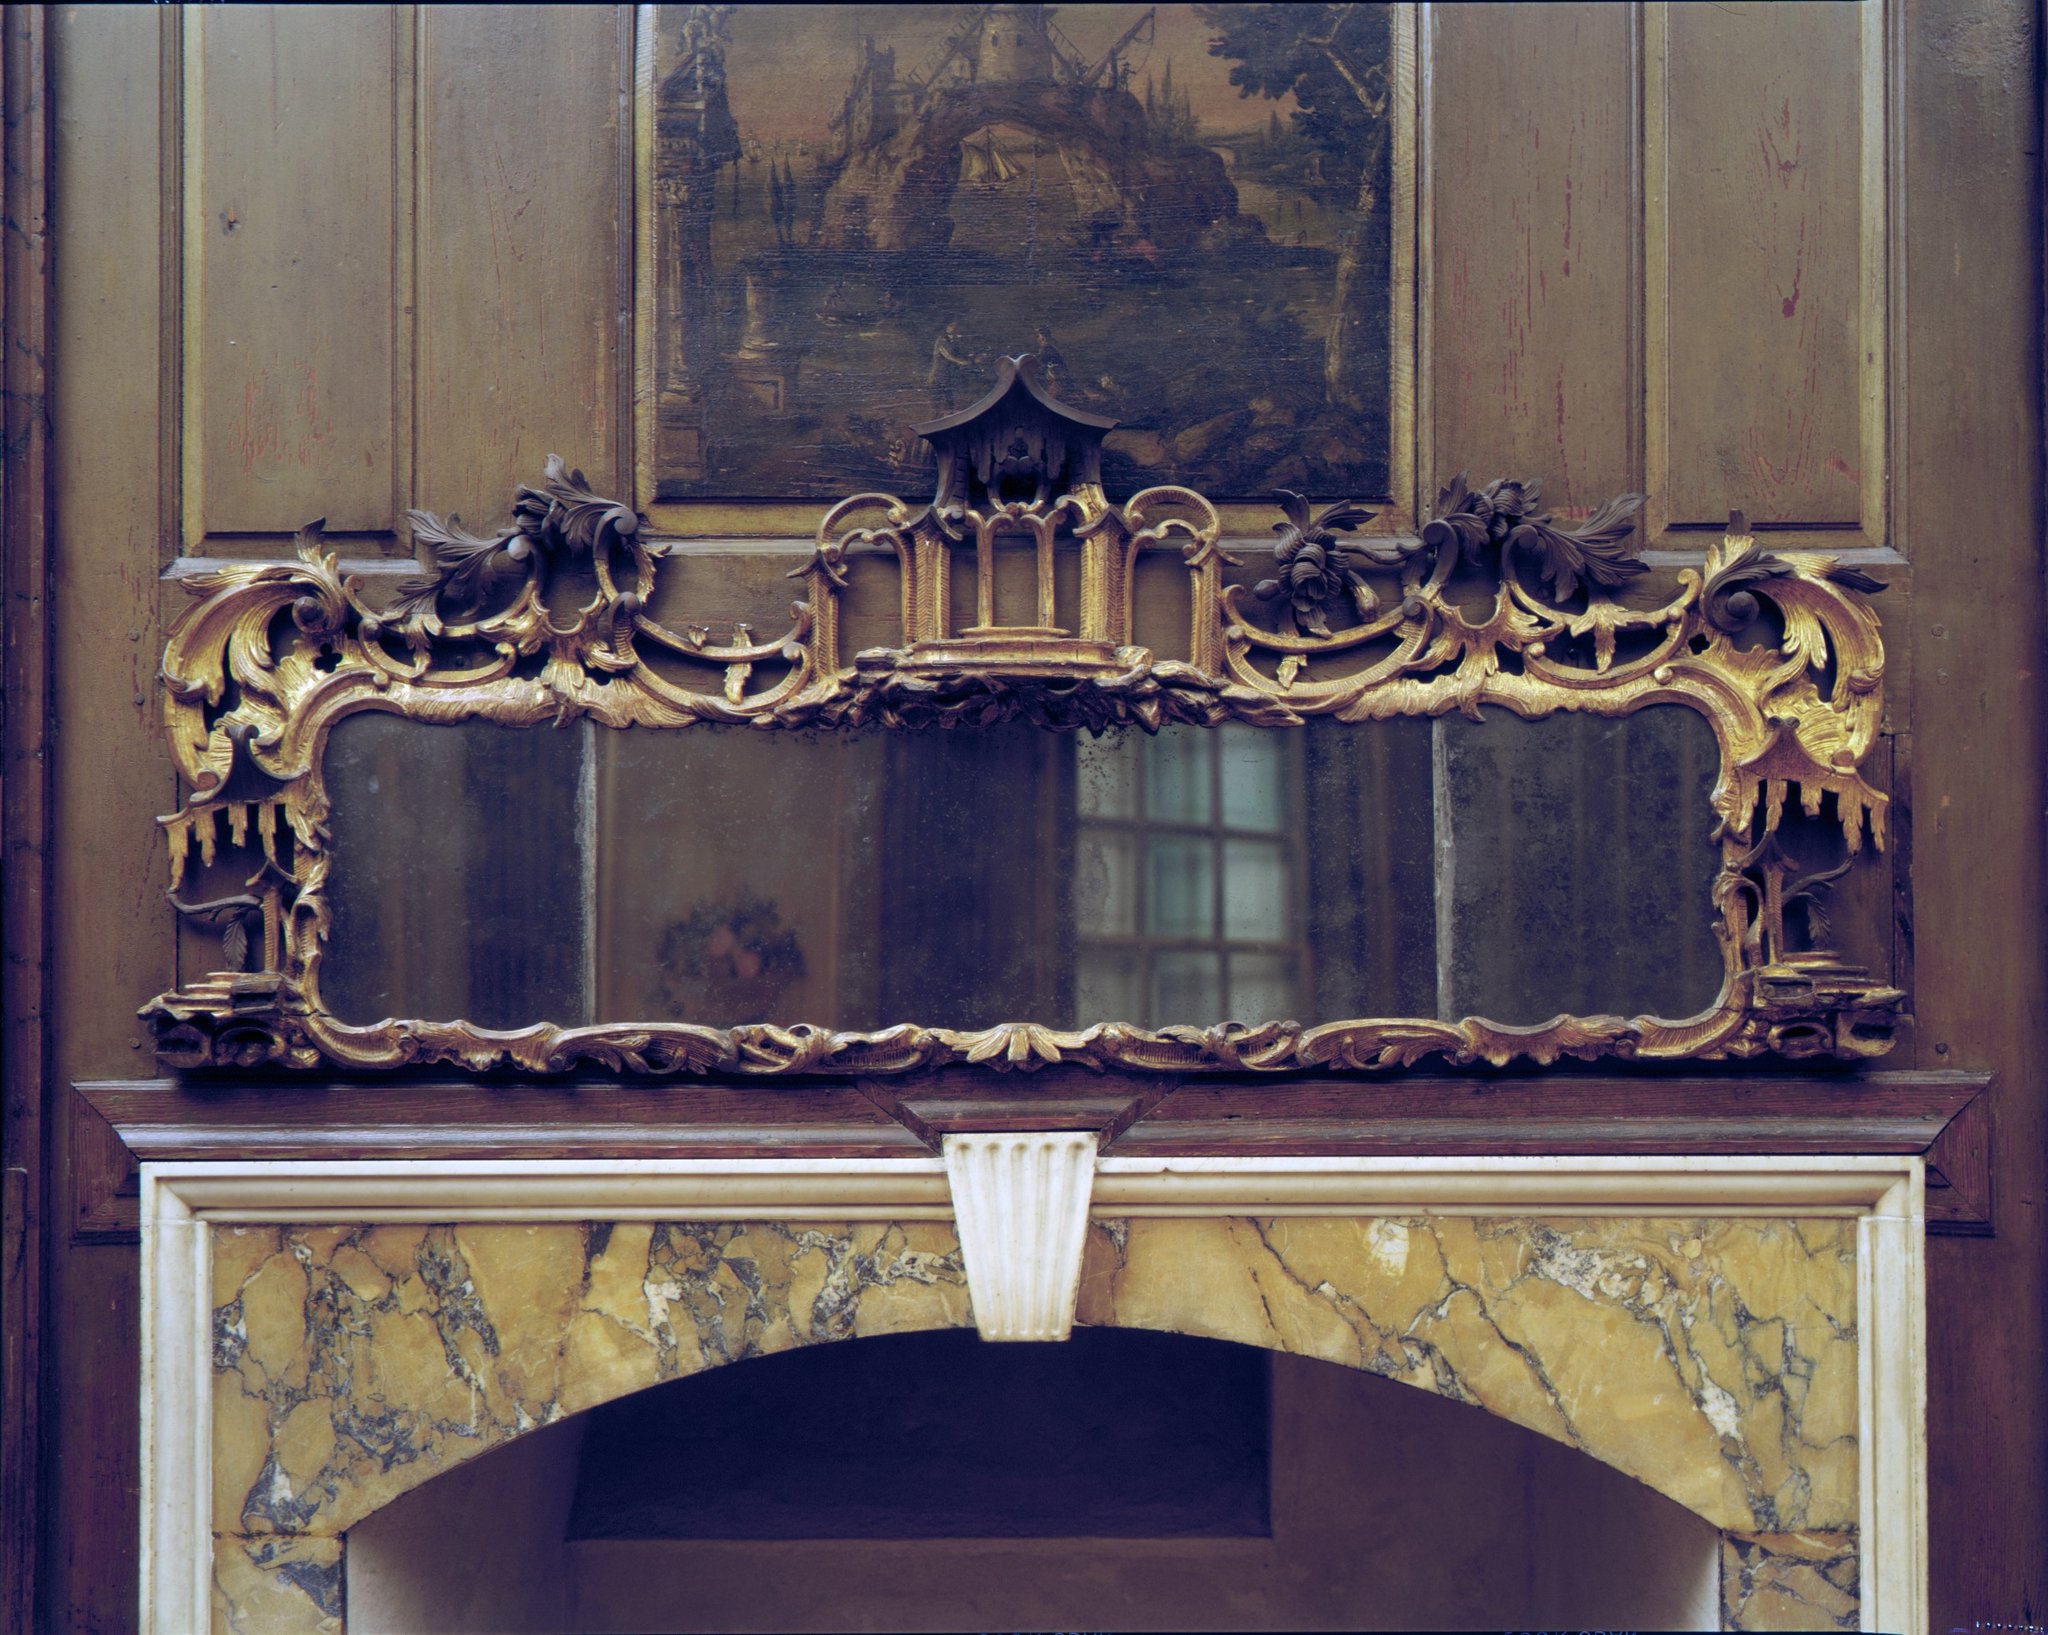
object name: looking glass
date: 1750-1775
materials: wood, plaster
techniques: gilding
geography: england